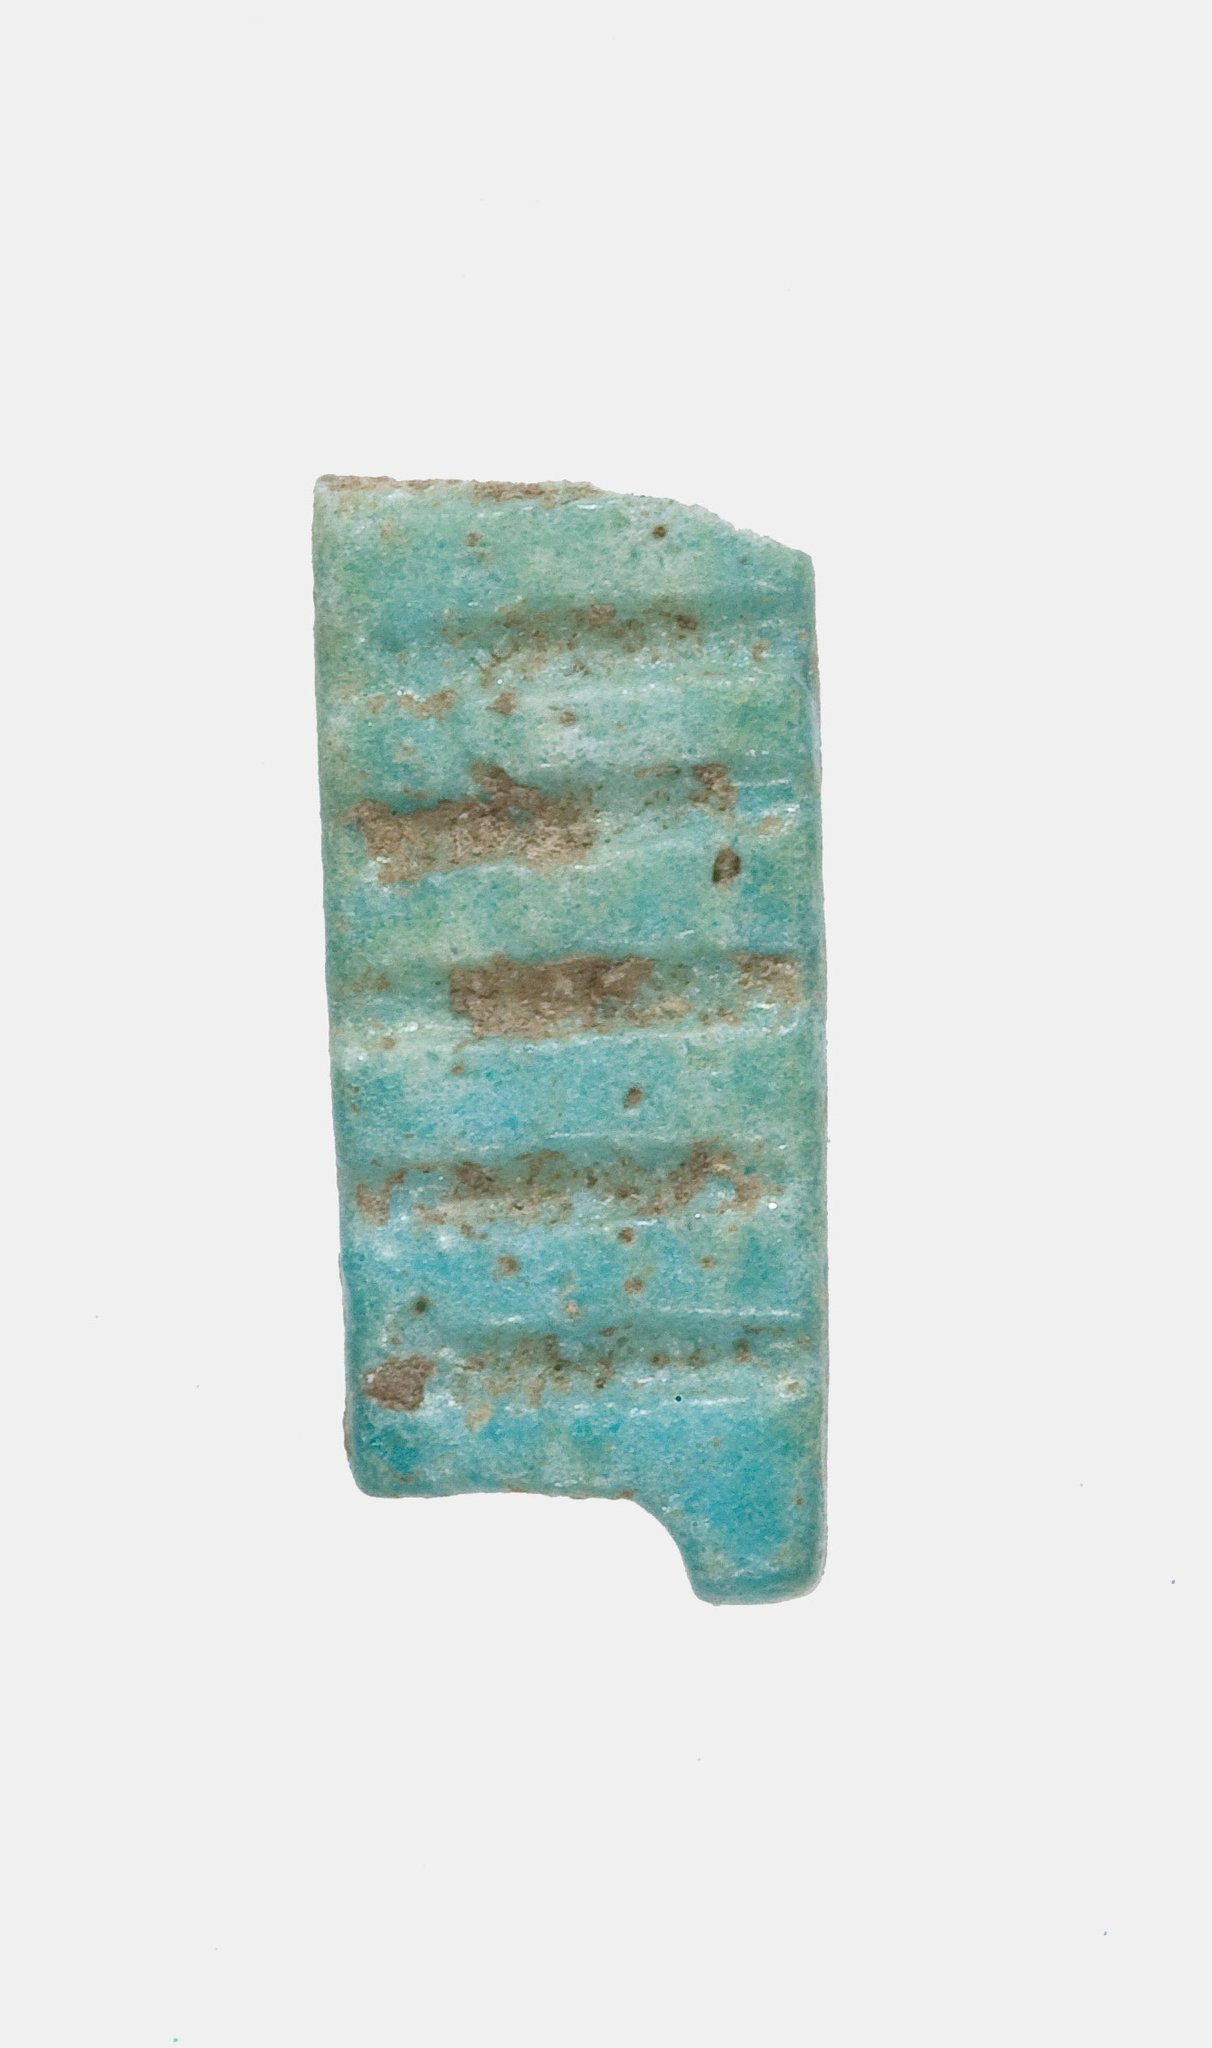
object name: necklace, bead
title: Amulet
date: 1802-1450 BCE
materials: faience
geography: egypt